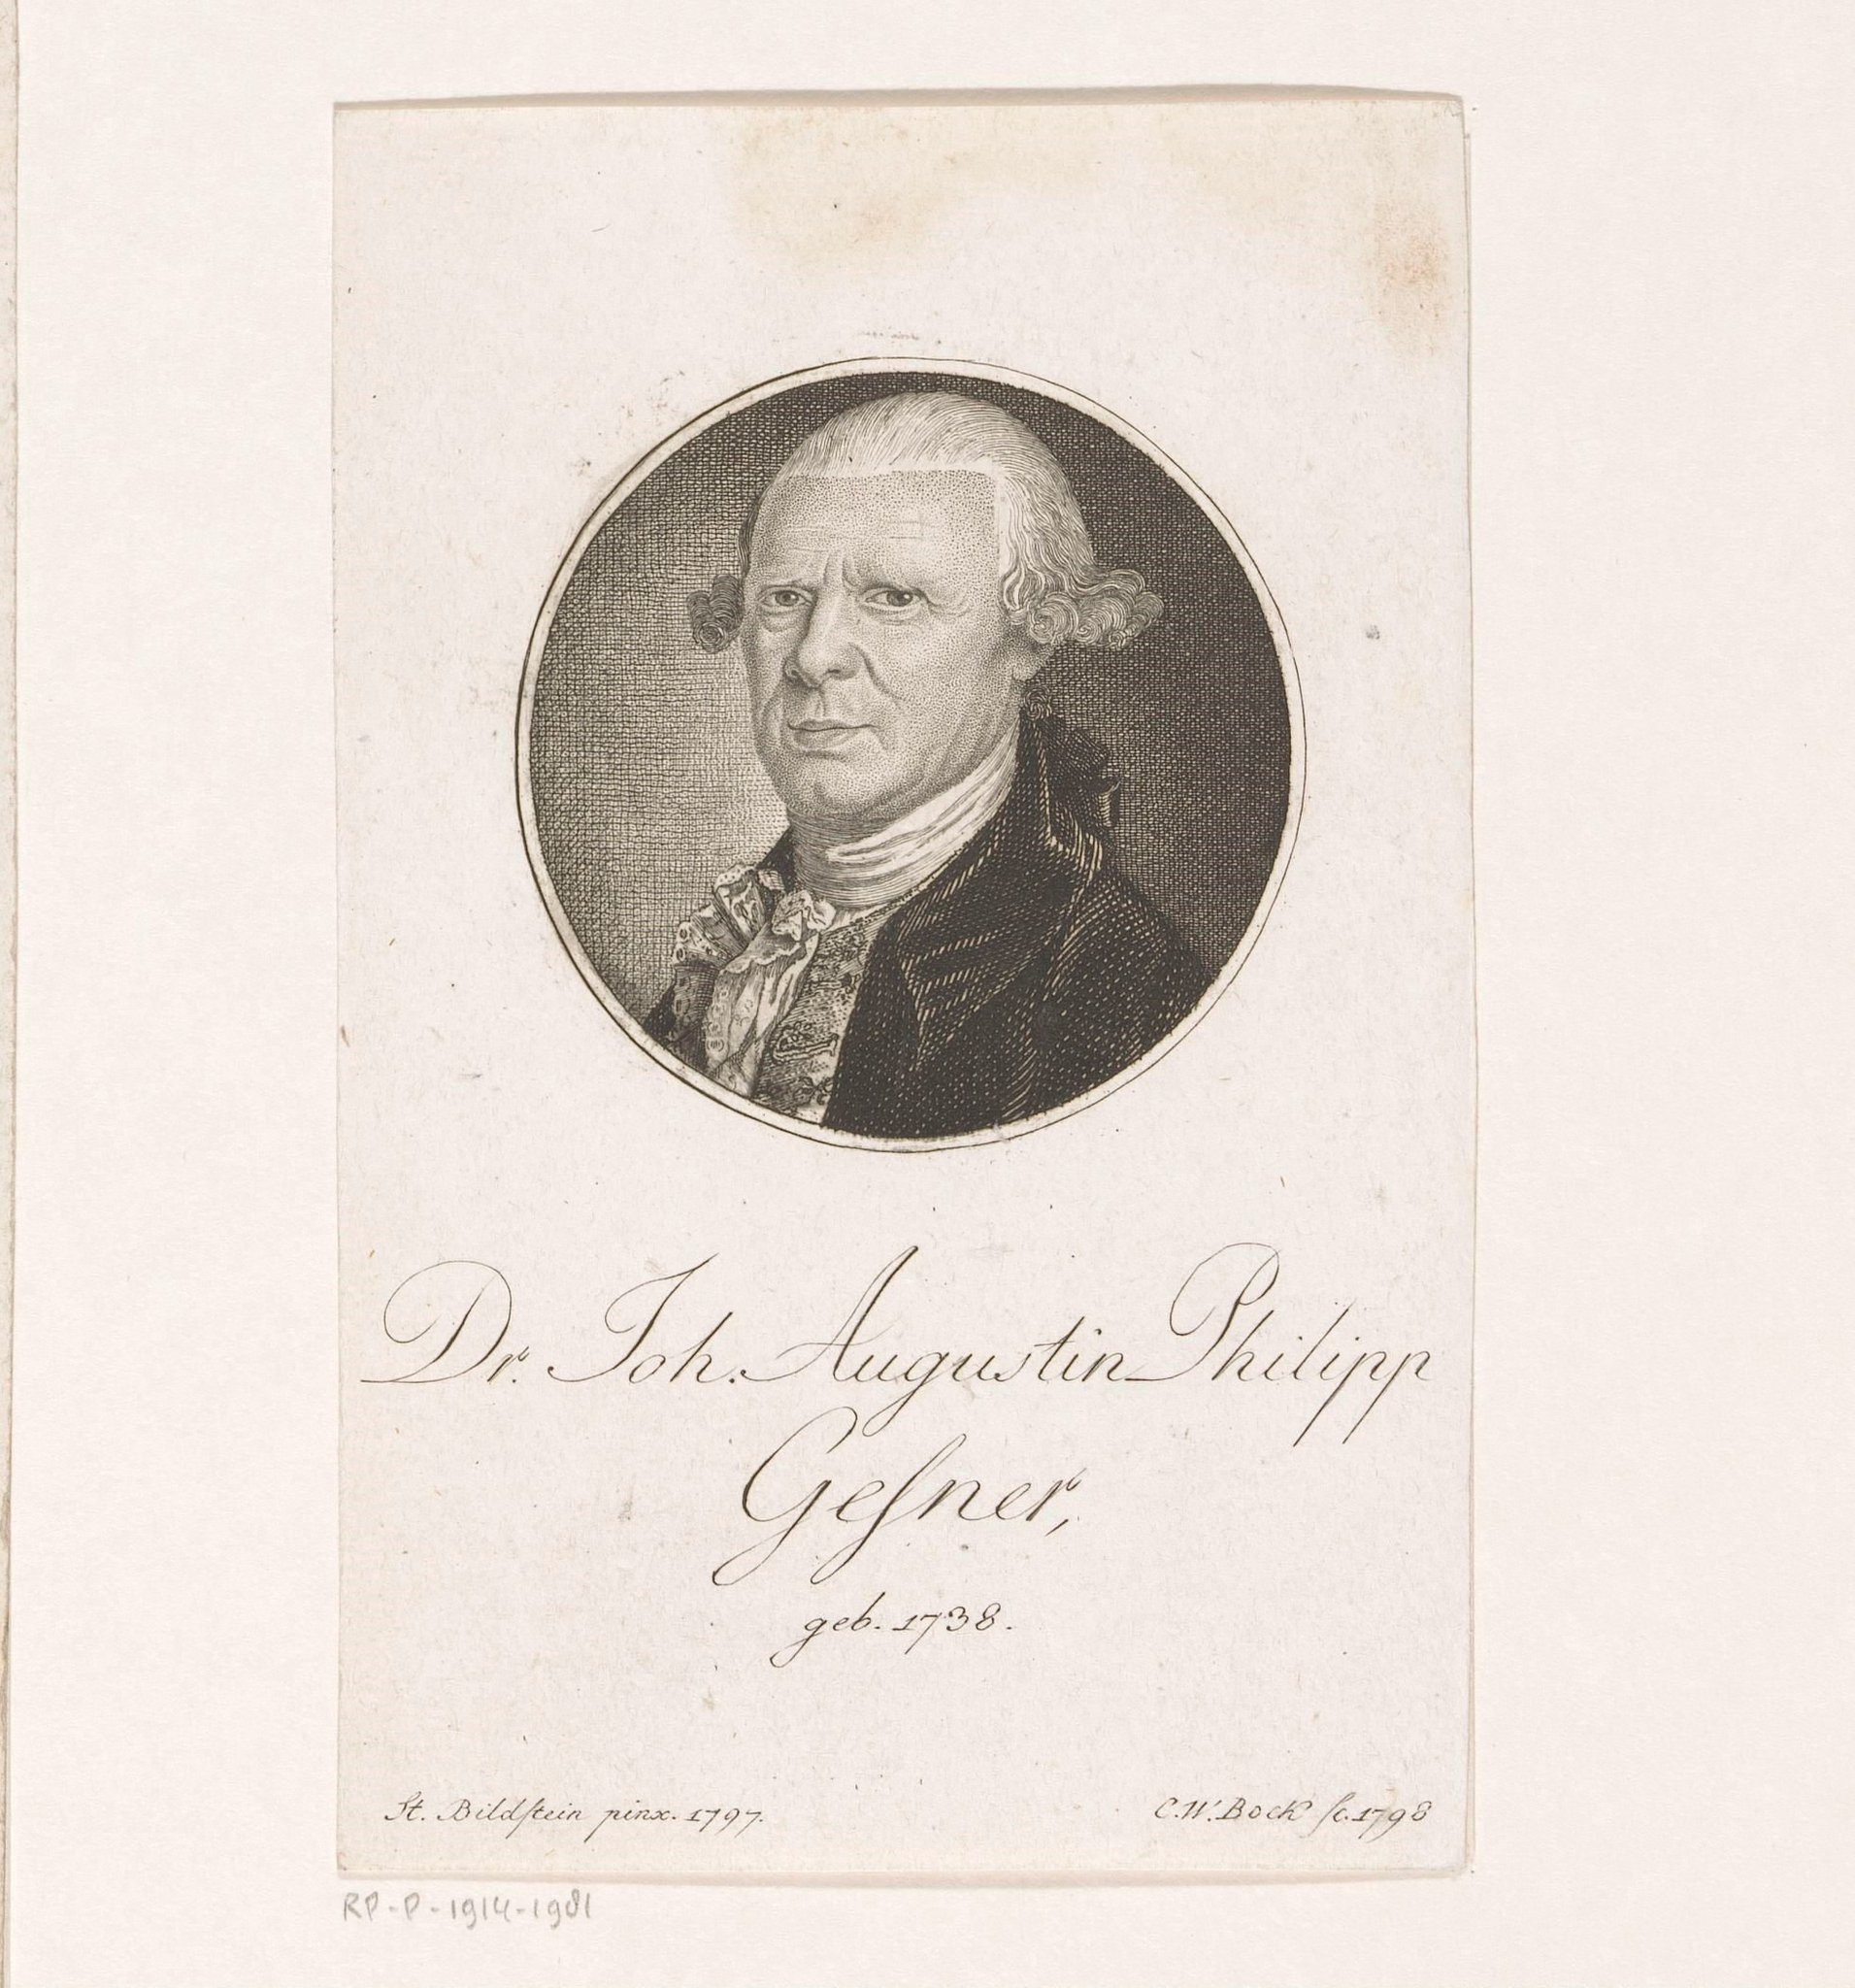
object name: print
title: Portret van Johann Augustin Philipp Gesner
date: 1798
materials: paper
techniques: engraving, etching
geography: nuremberg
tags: historical persons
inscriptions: collector's mark: Lugt 2228